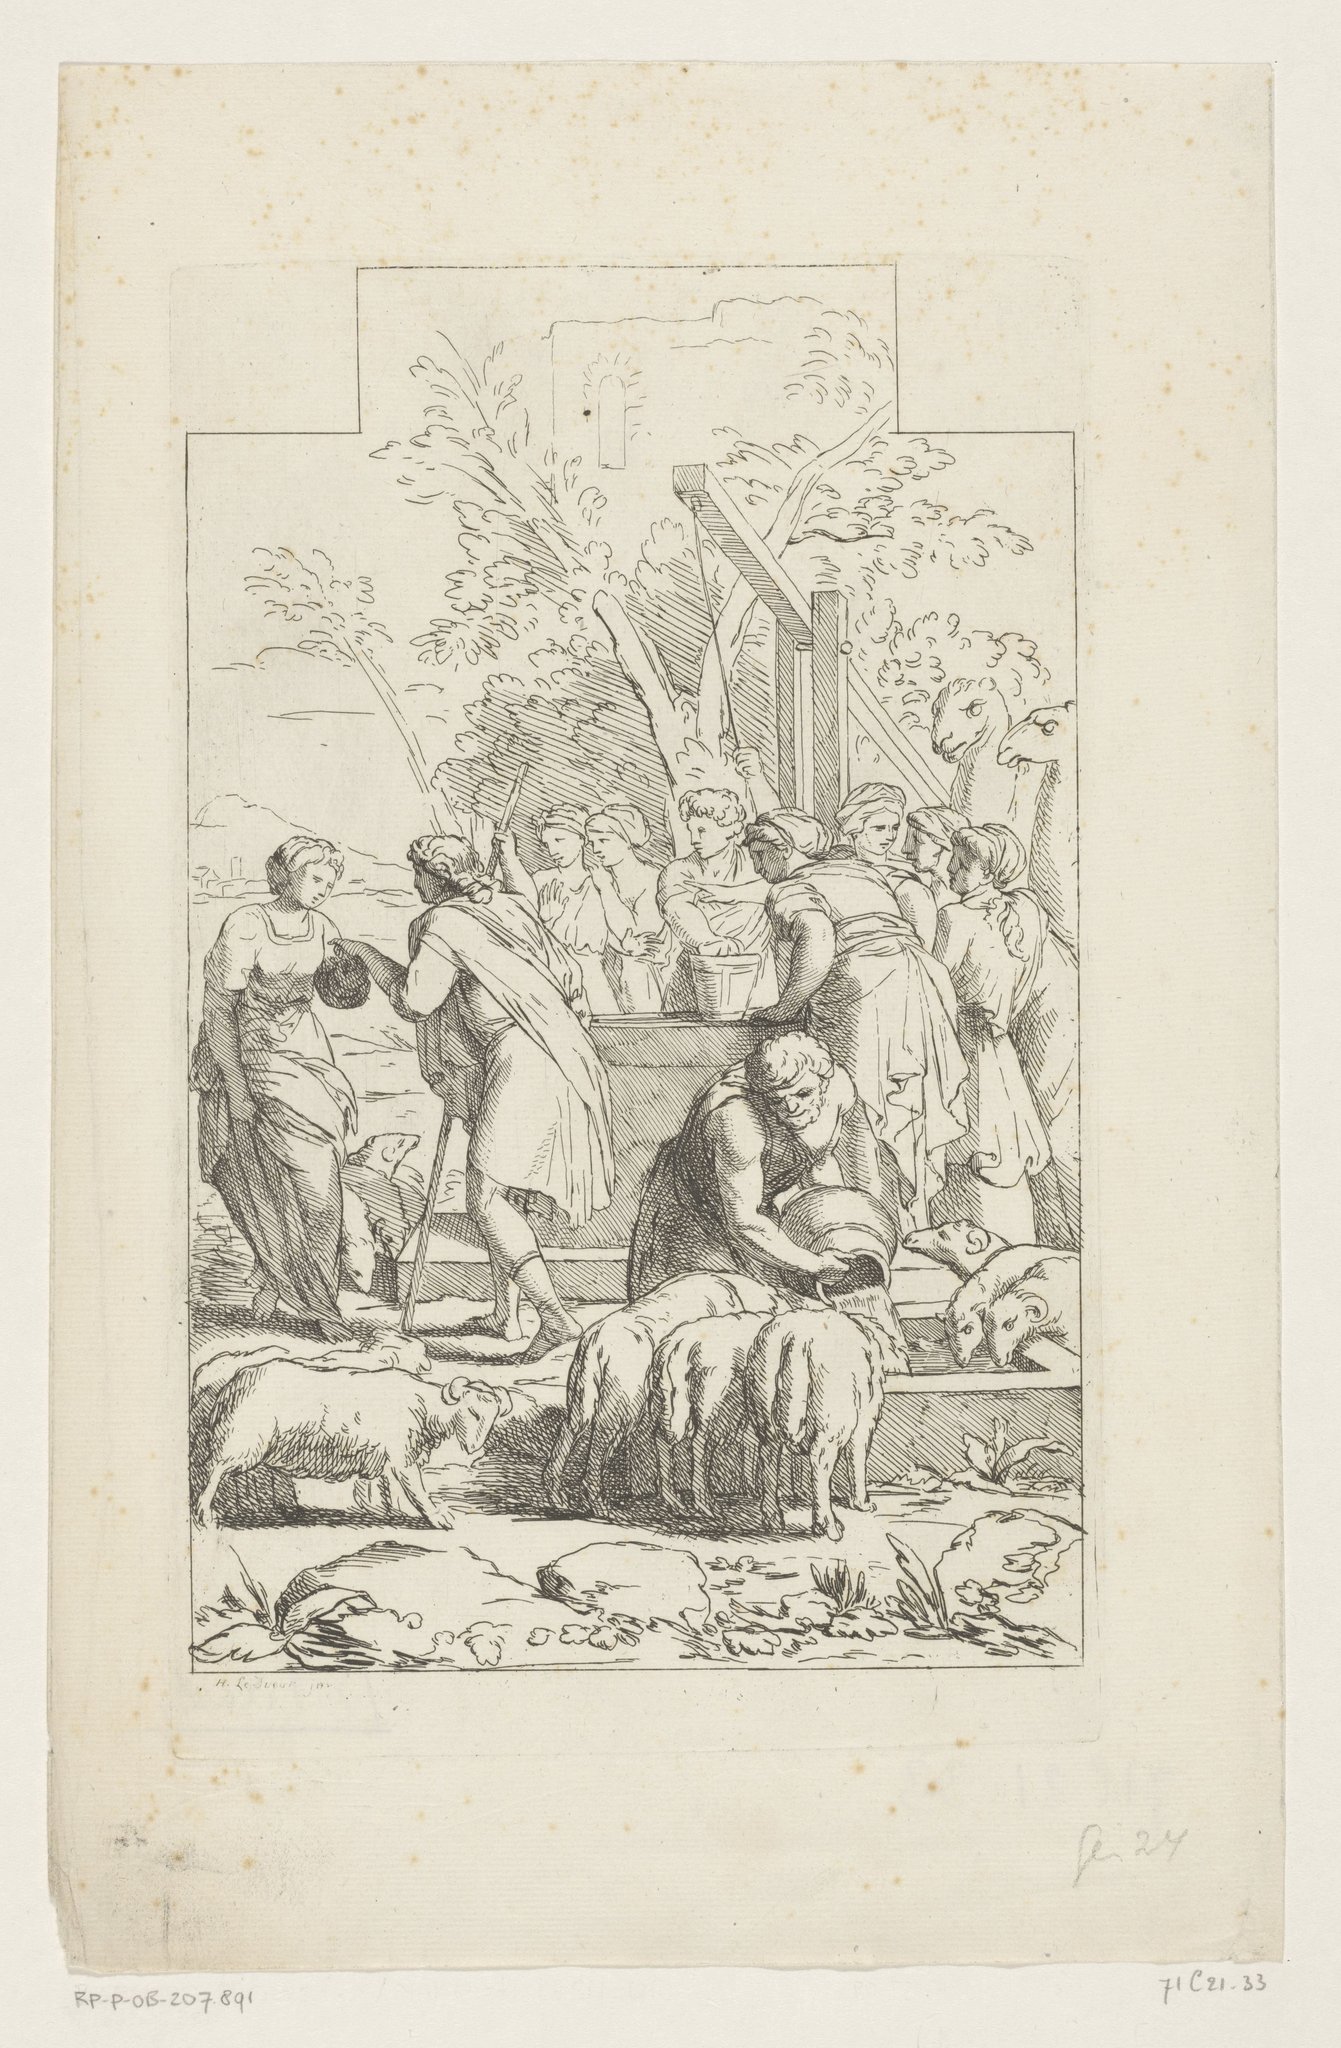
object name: print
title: Rebekka en Eliëzer bij de put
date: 1683-1733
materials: paper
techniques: etching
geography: france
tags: rebekah offers eliezer a drink from her pitcher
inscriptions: collector's mark: Lugt 2228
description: Rebekka ontmoet Eliëzer, de knecht van Abraham, bij de put. Rechts op de achtergrond diens kamelen. Op de voorgrond giet een man water uit een kruik in een drinkbak voor de schapen.